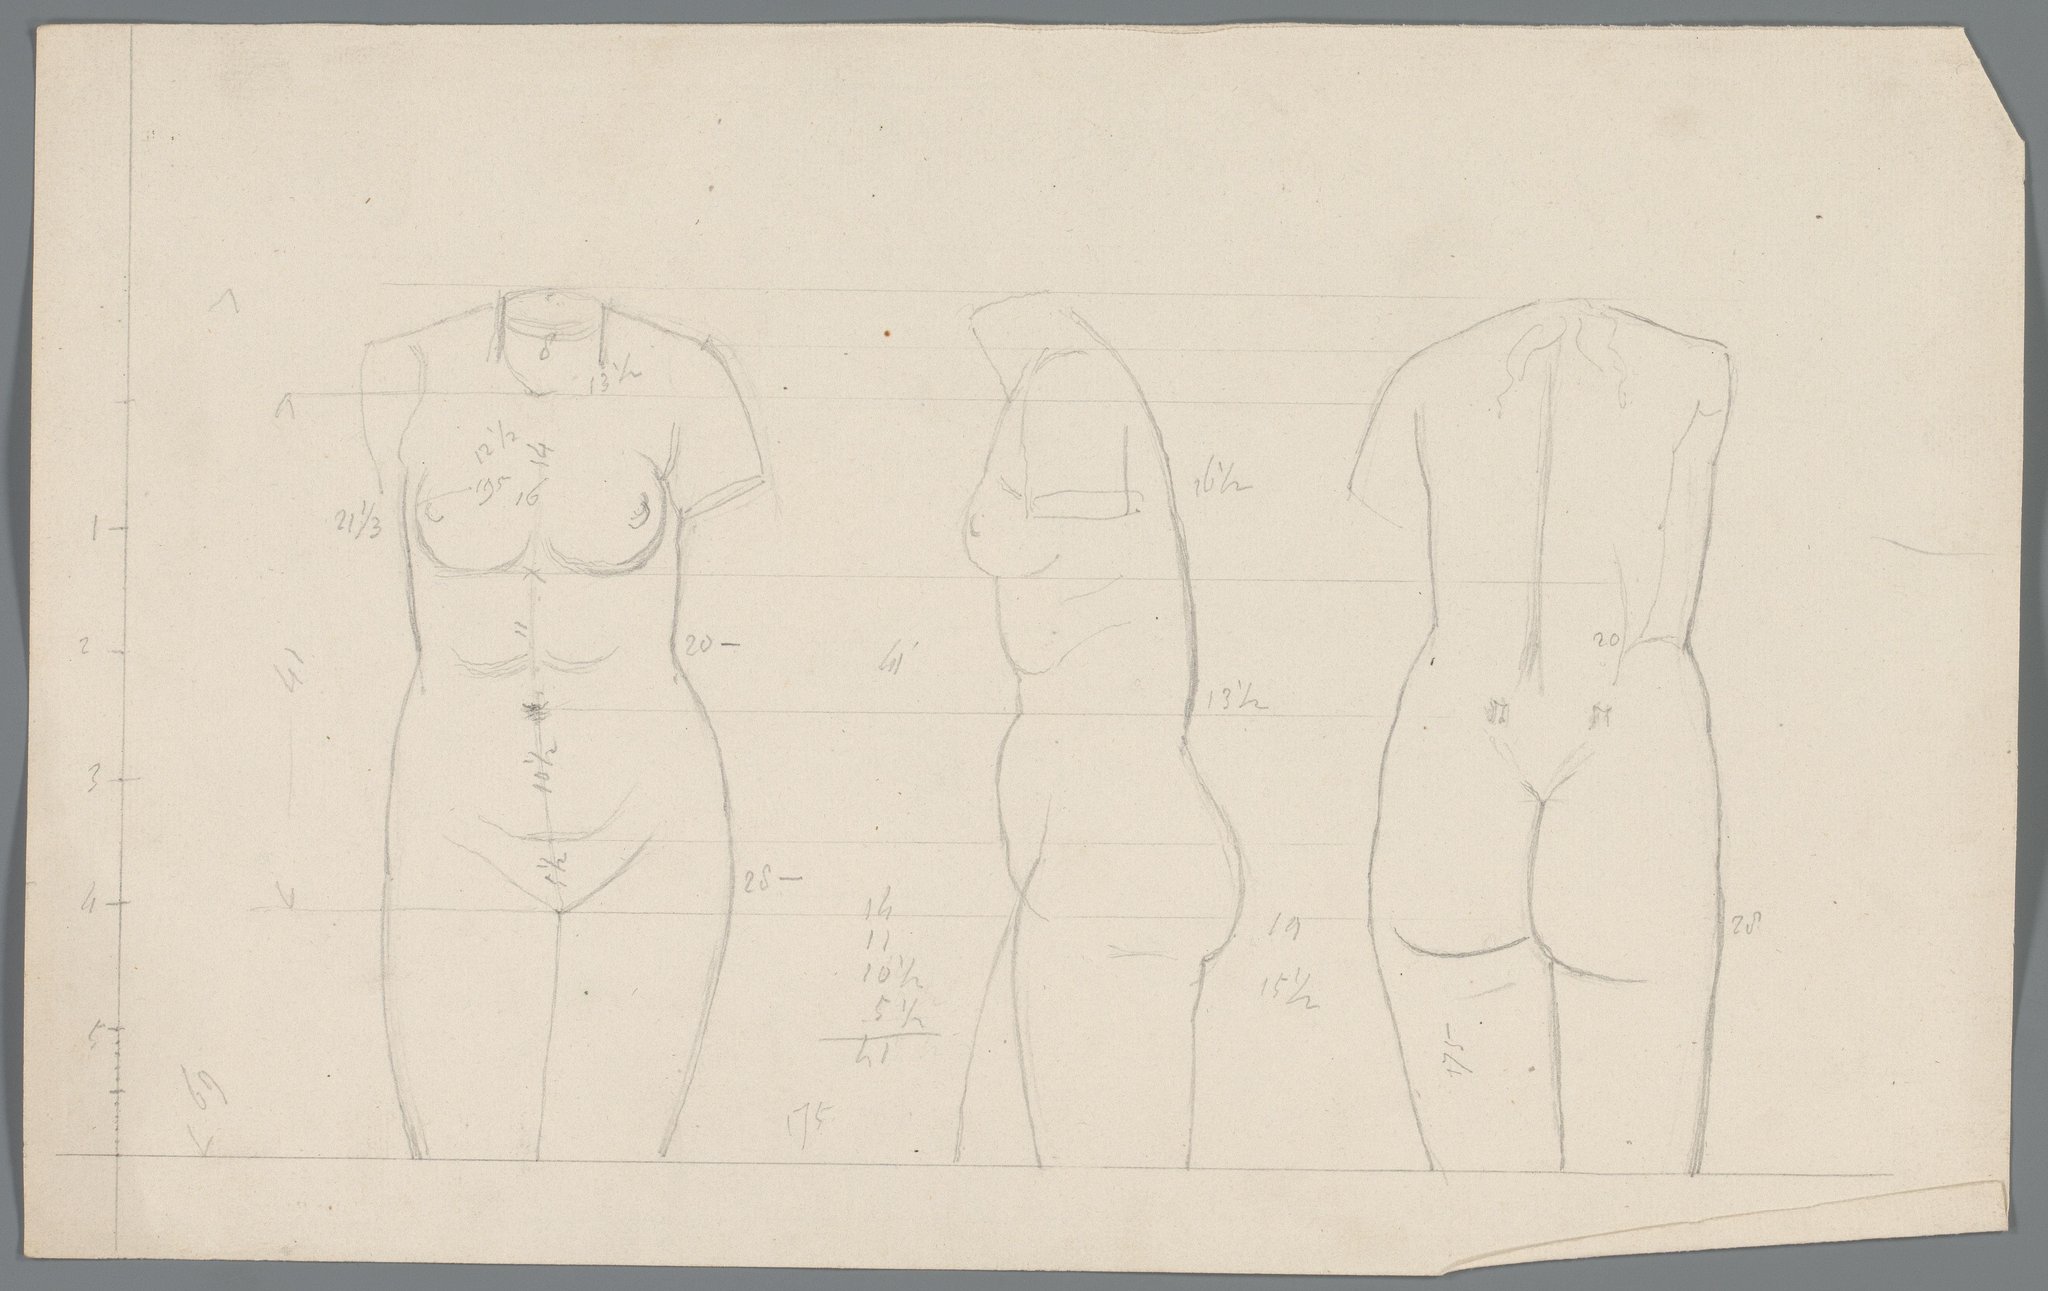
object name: drawing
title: Proportiestudie van een vrouwentorso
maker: jacobus everhardus josephus van den berg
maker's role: draughtsman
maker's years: 1802-1861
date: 1812-1861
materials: paper, pencil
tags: torso - aa - female human figure, standing figure (canon, proportions) - aa - female human figure